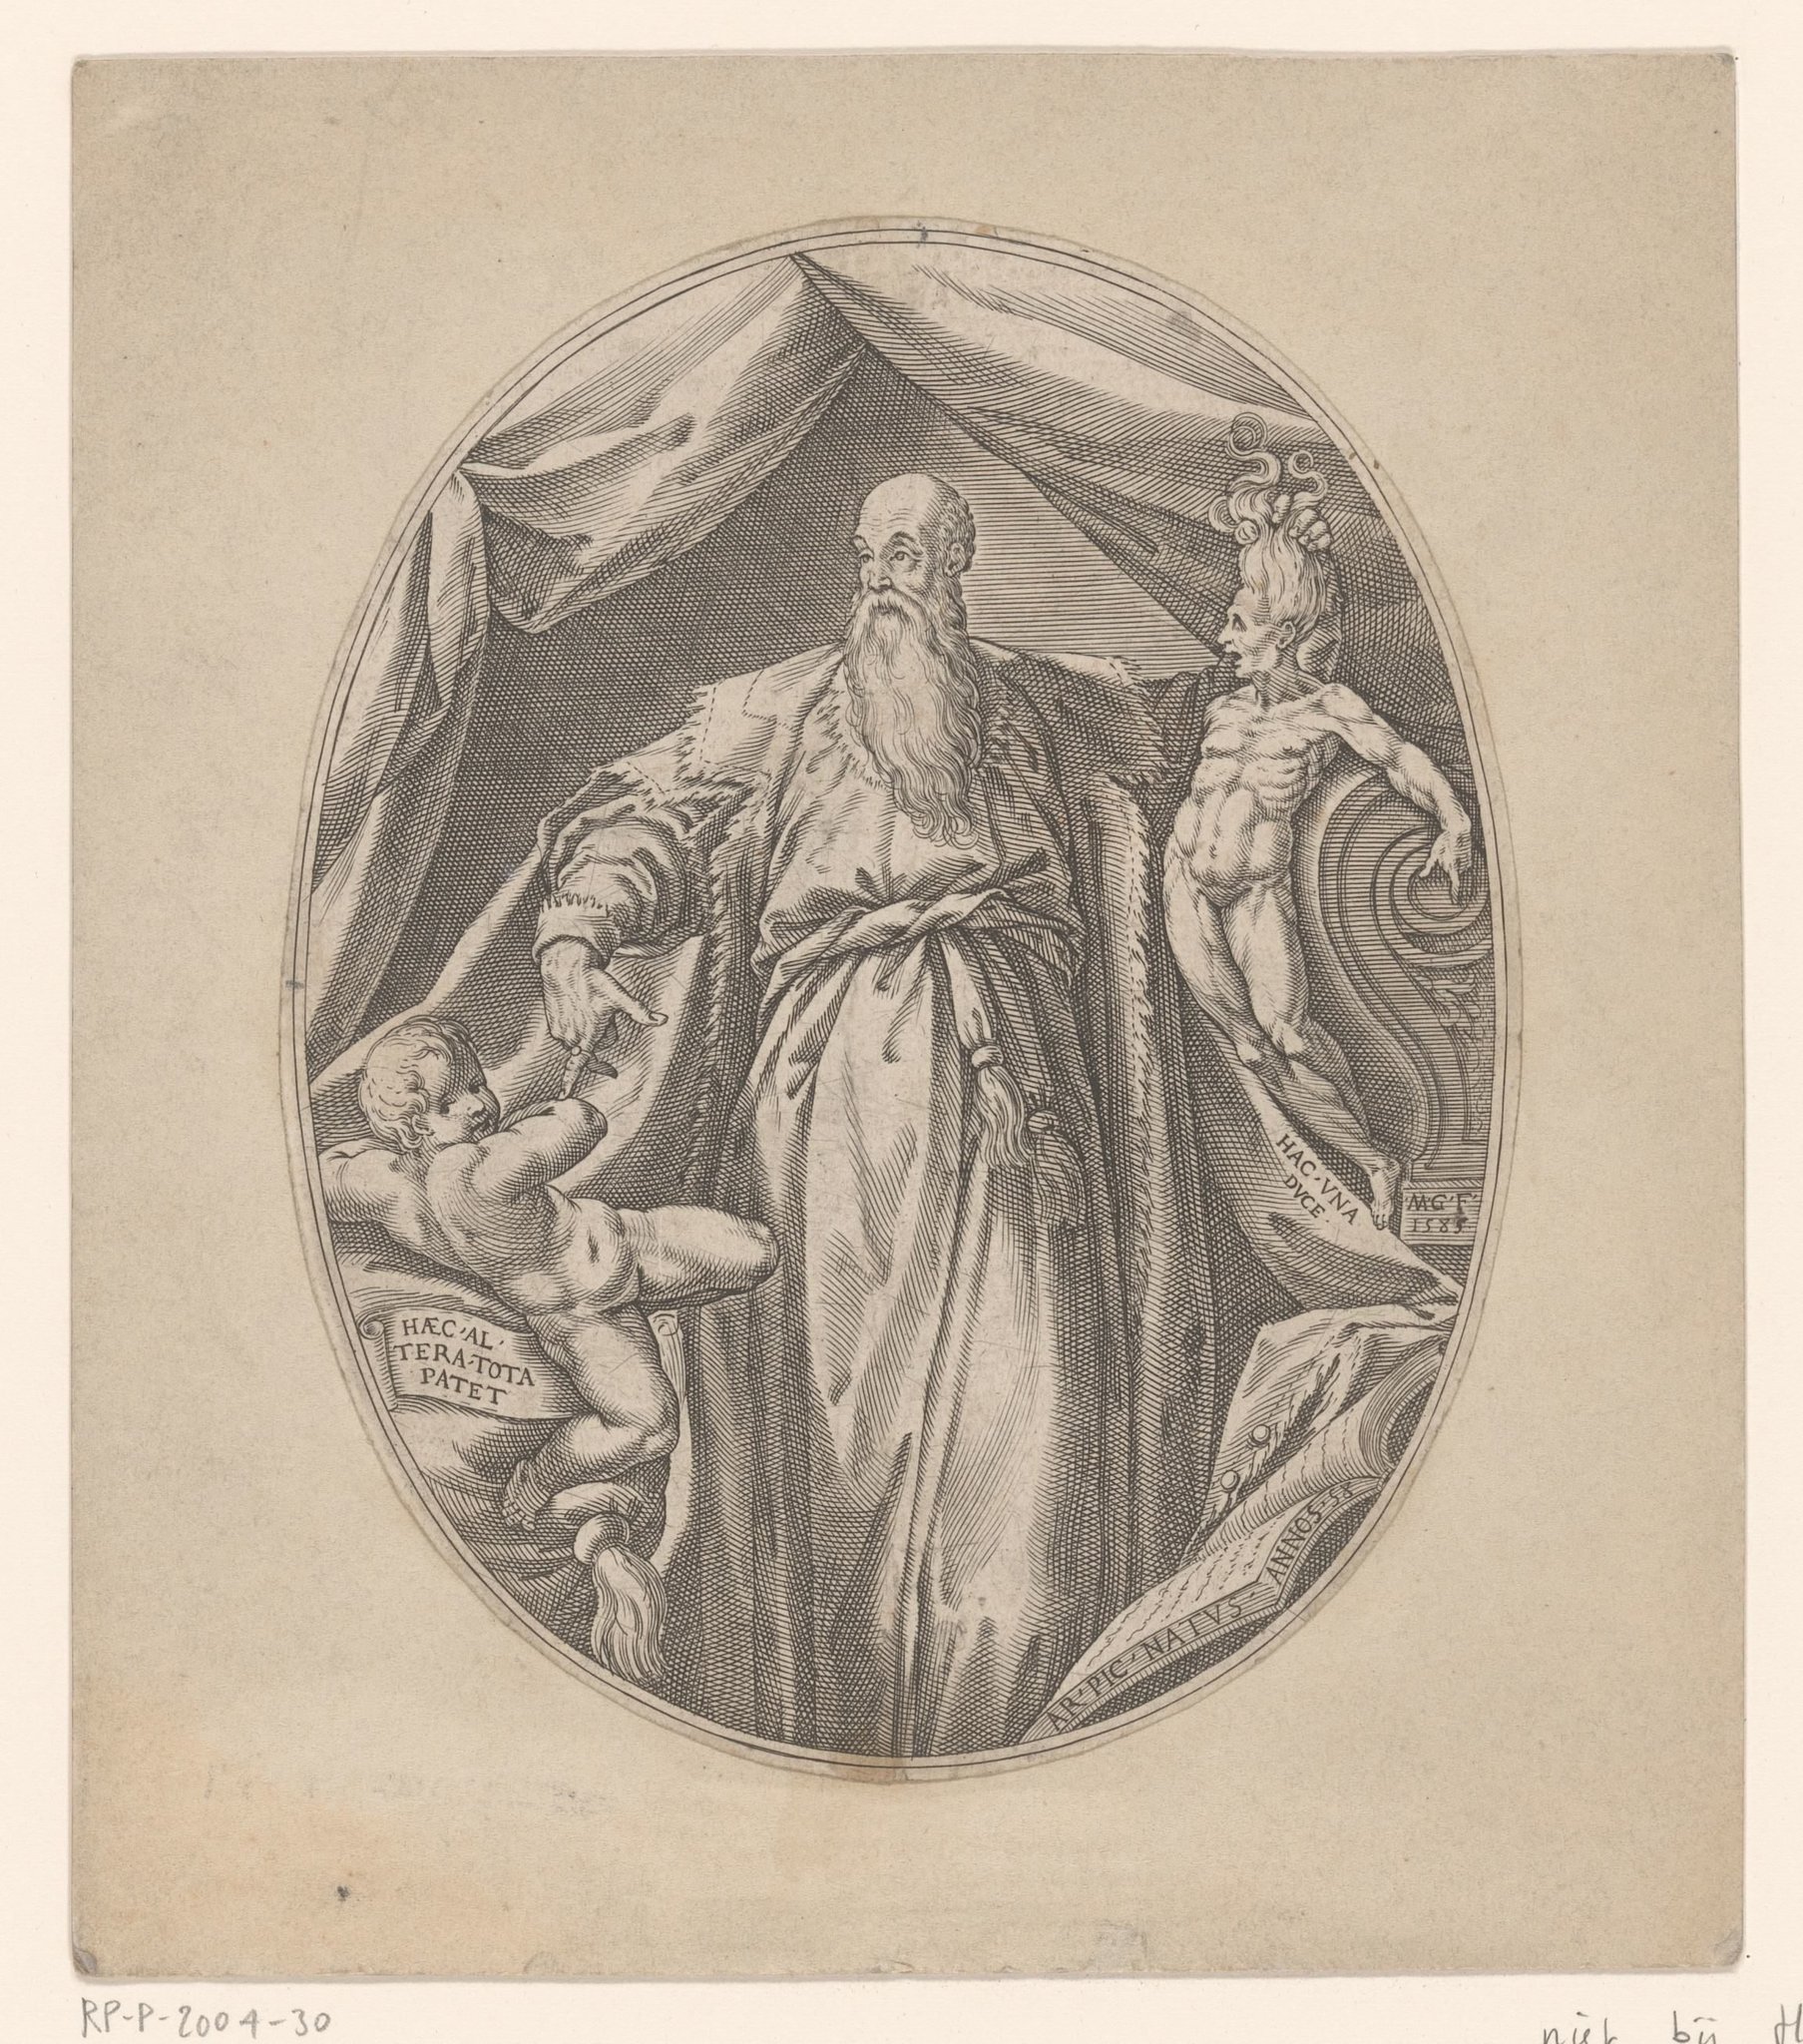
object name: print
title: Portret van Archangelo Piccolomini op 58-jarige leeftijd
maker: matthäus greuter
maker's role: print maker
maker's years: 1564-1638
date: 1585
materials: paper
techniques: engraving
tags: scholar, philosopher, historical persons, medicine, medical science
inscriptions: collector's mark: Lugt 2760, collector's mark: Lugt 2228